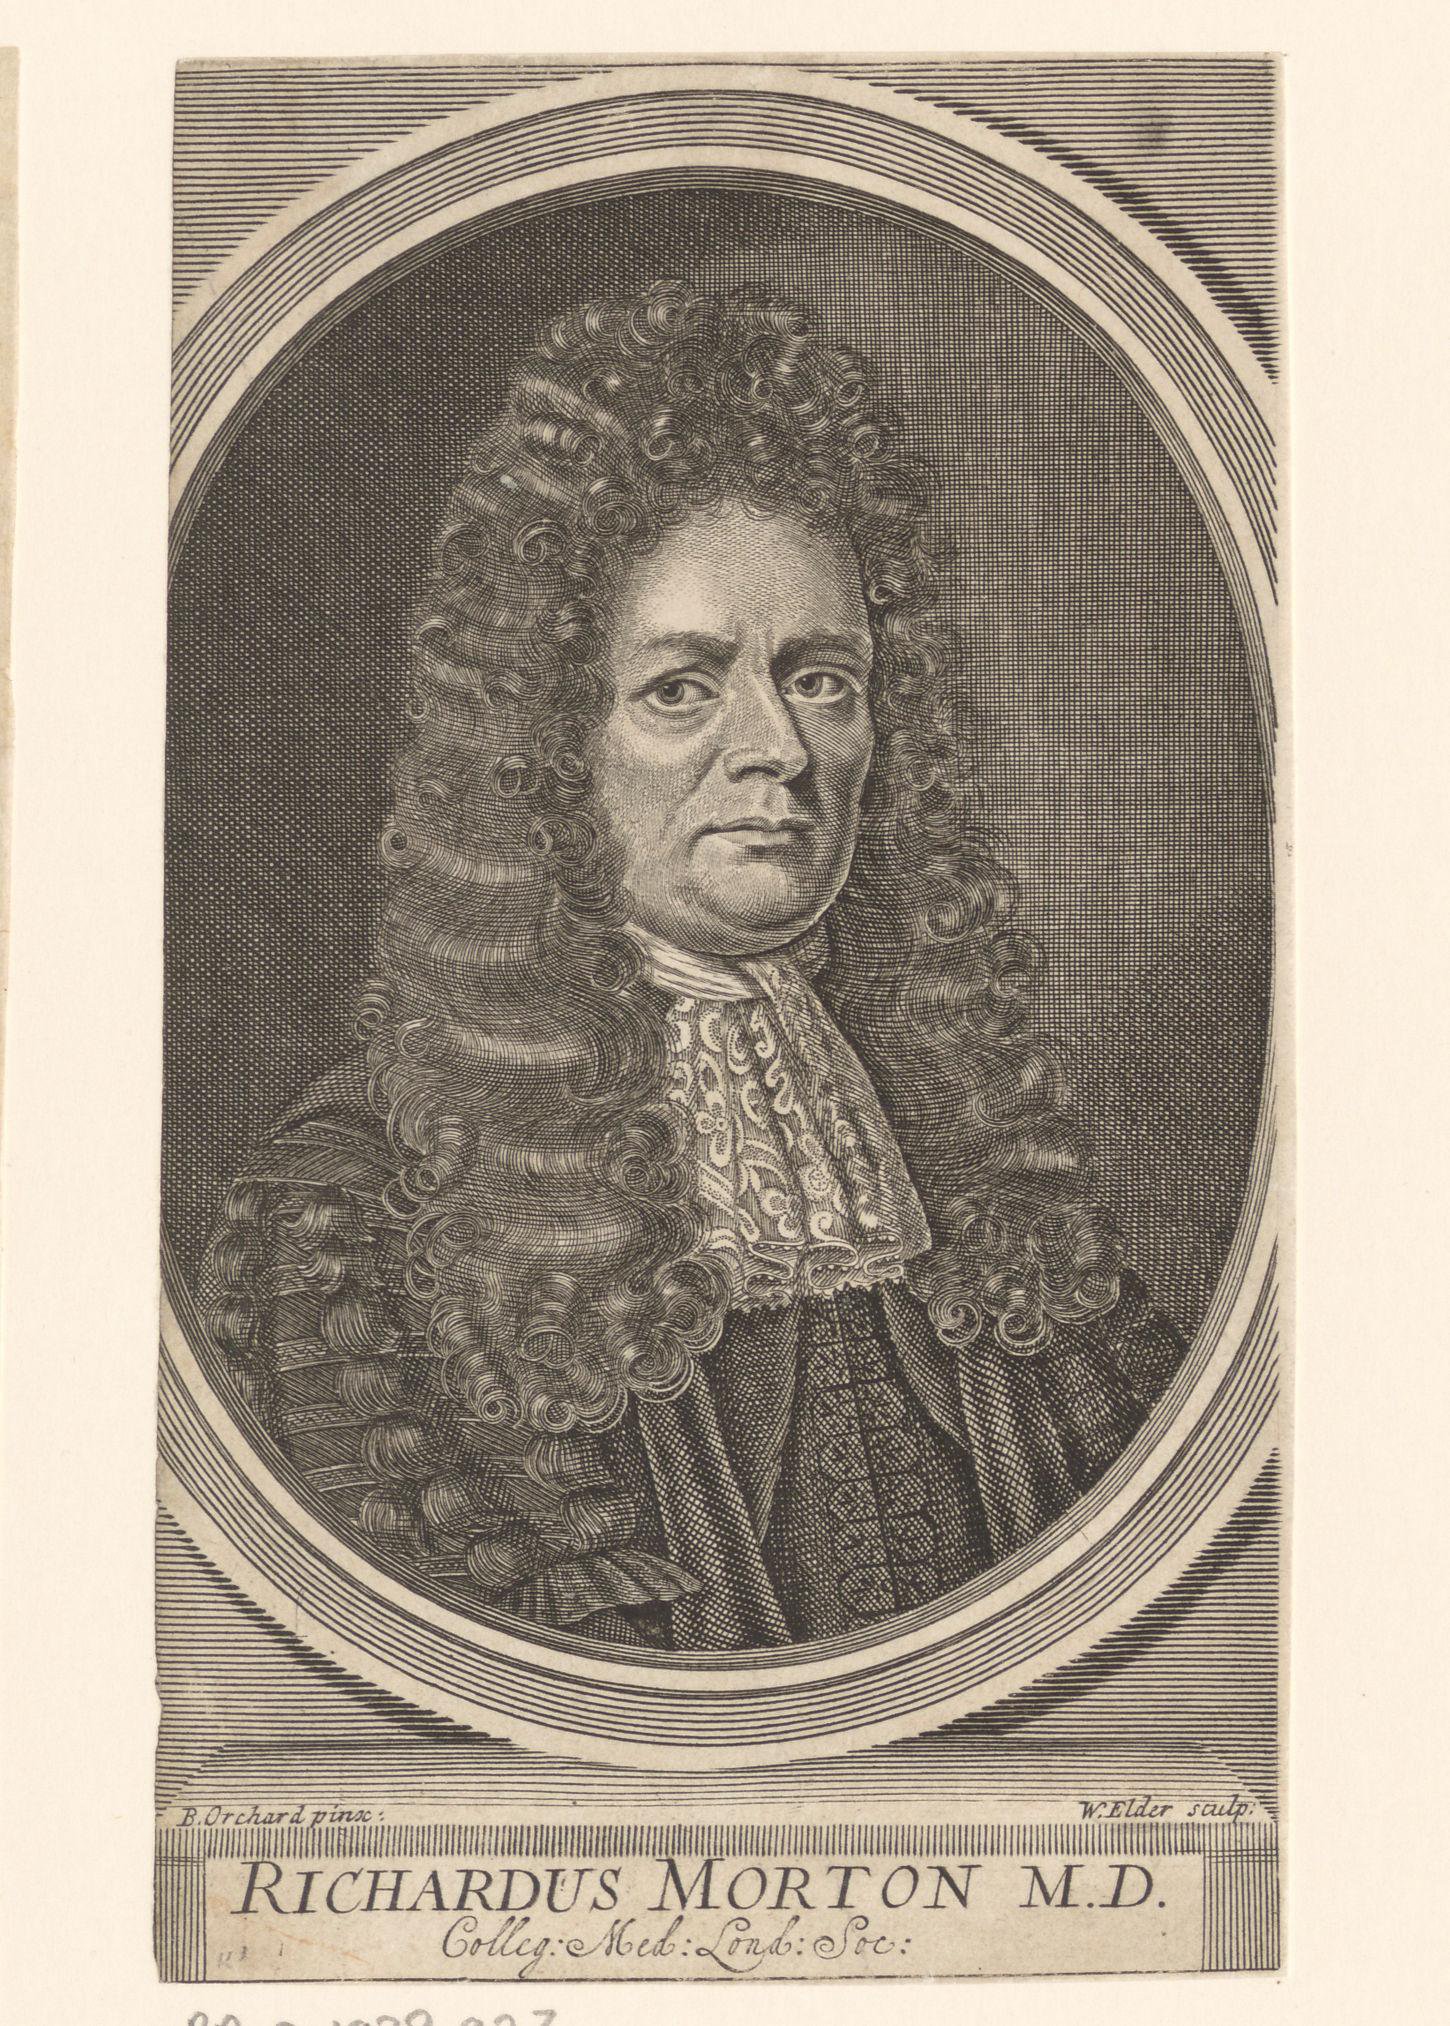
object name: book illustration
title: Portret van Richard Morton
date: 1692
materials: paper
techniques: engraving, etching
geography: london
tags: historical persons, physician, doctor (+ portrait of scholar, scientist)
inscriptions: collector's mark: Lugt 2228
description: Prent uit: Morton, Richard. Pyretologia, seu, Exercitationes de morbis universalibus. Londen: Samuel Smith, 1692.